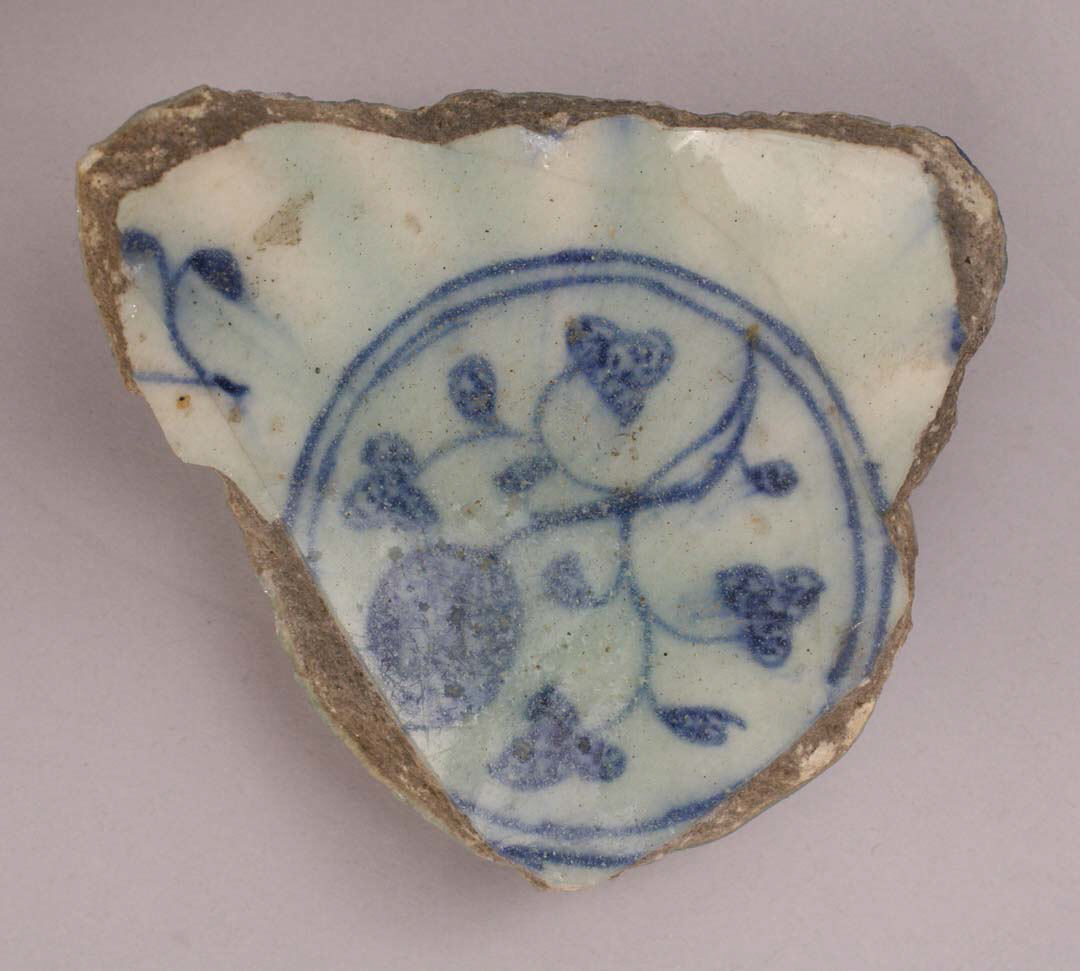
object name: fragment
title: Ceramic Fragment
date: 1201-1600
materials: glaze, stonepaste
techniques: painting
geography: egypt